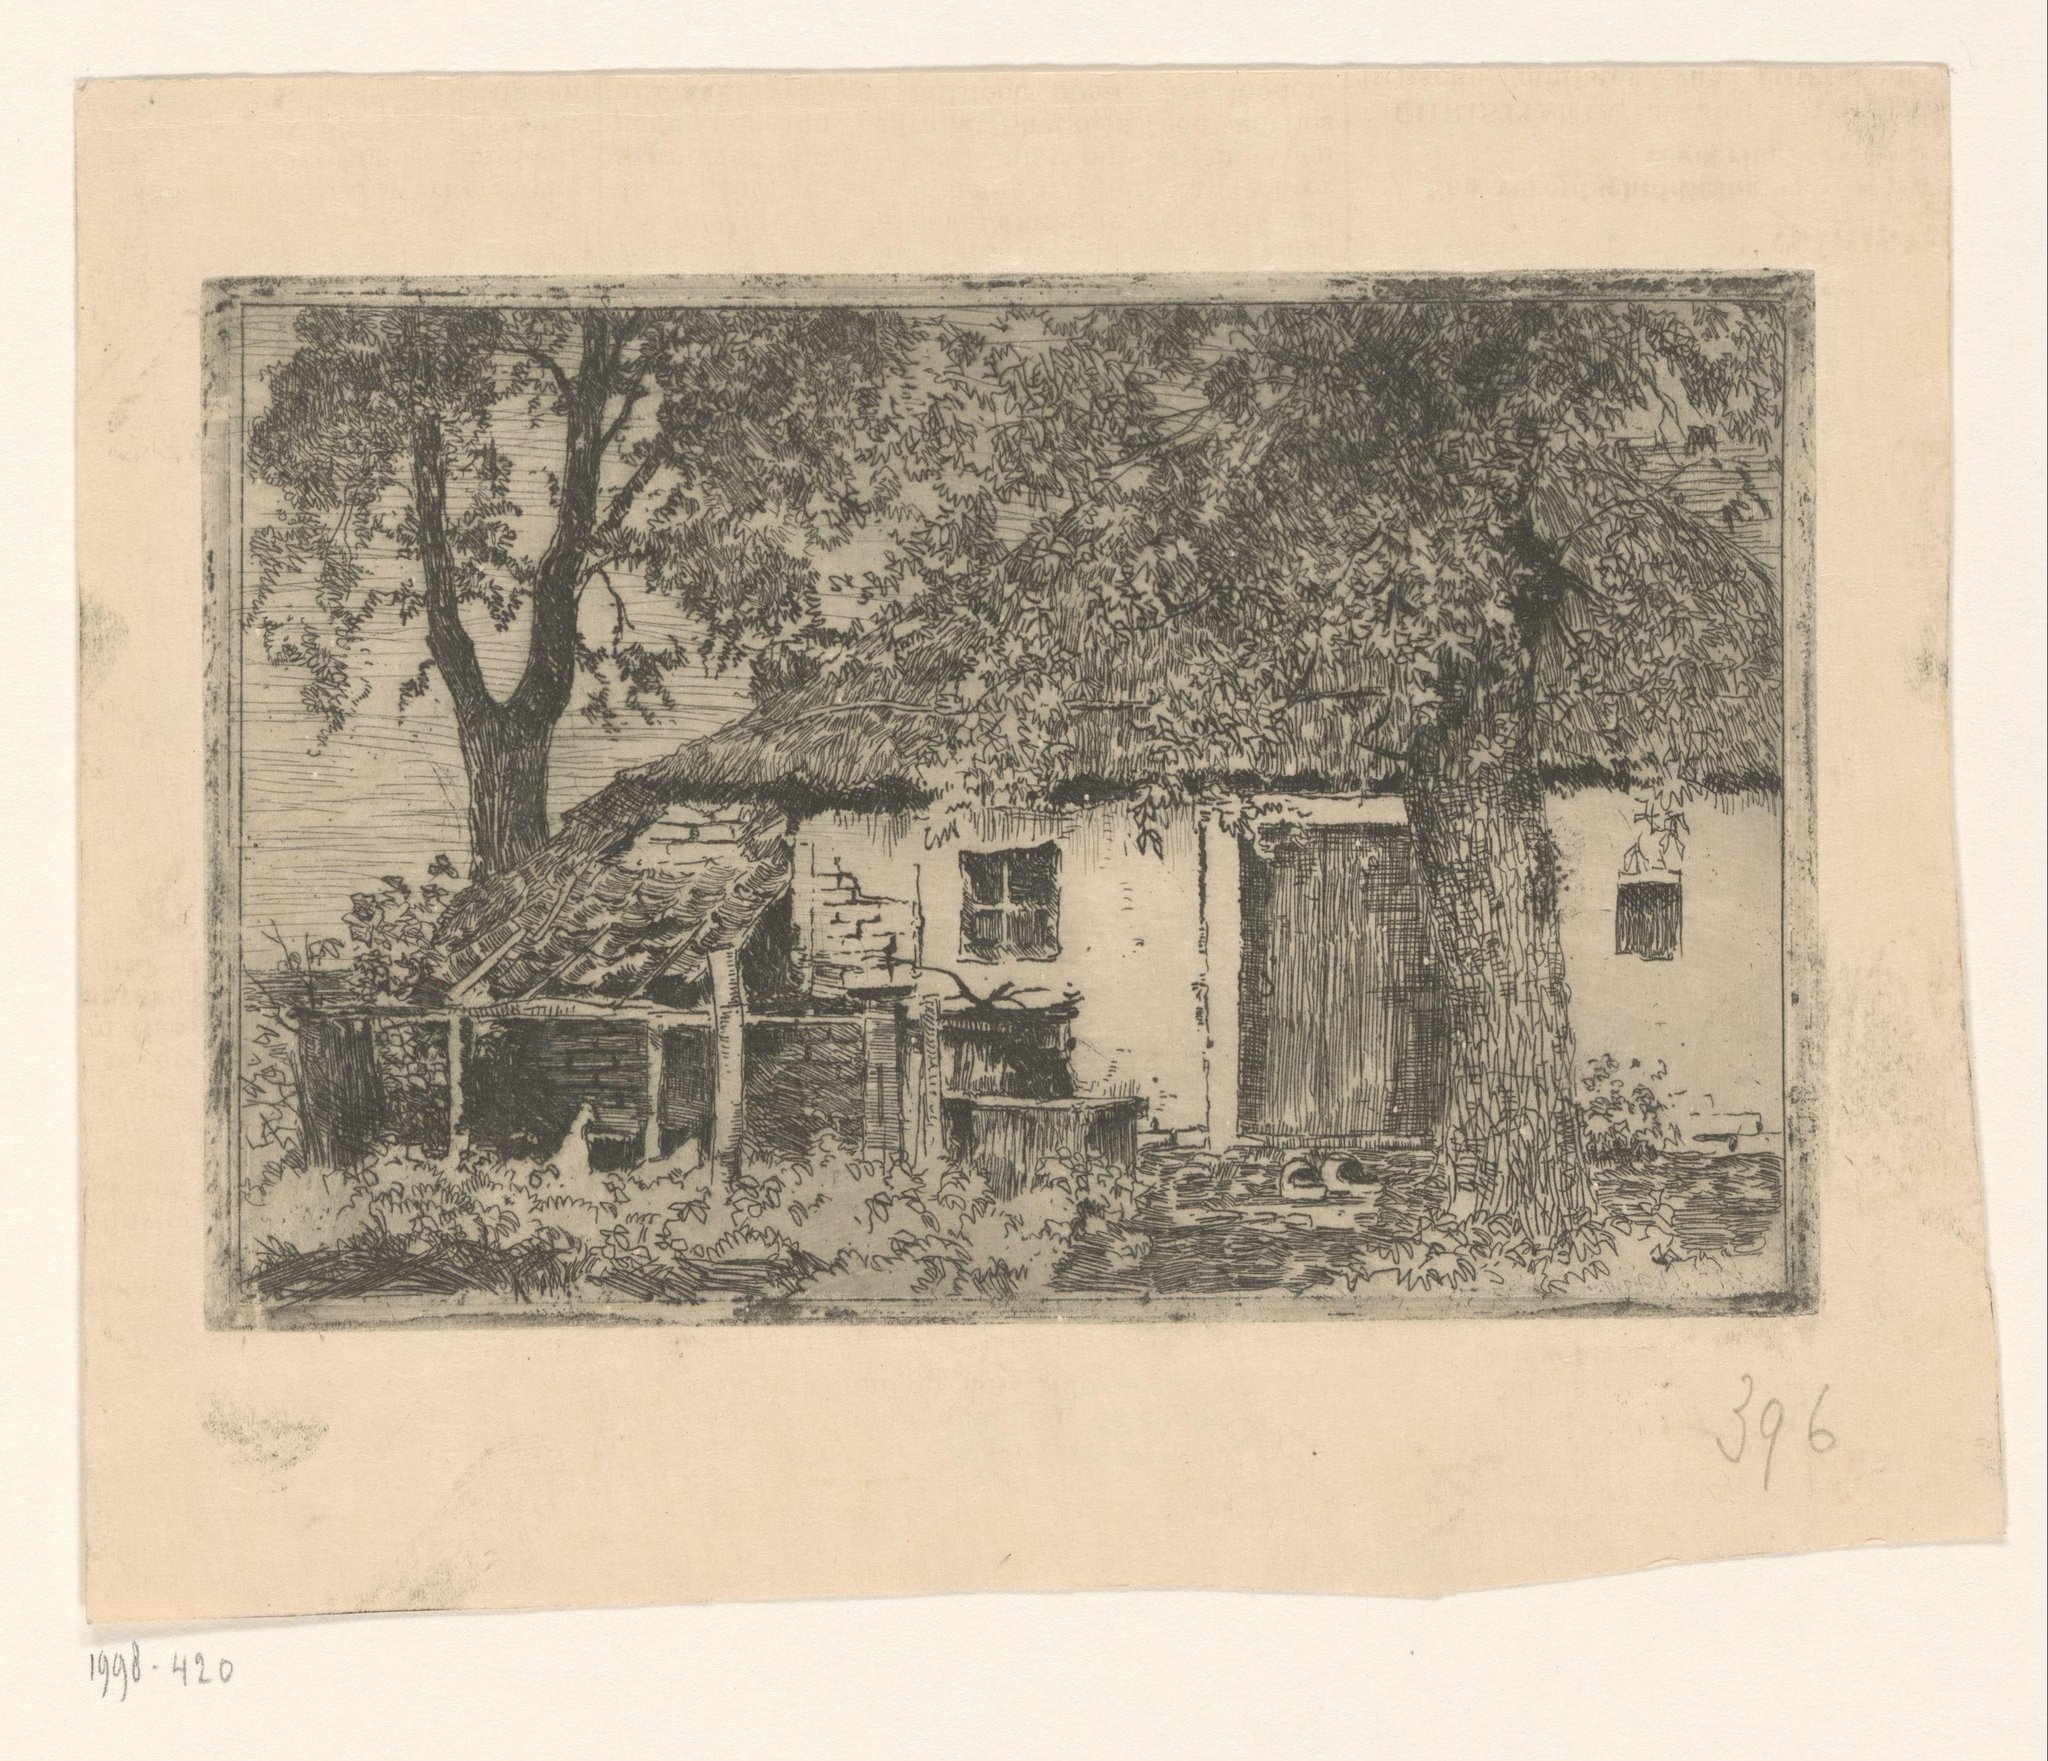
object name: print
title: Boerderij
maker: cornelis vreedenburgh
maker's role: draughtsman, print maker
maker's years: 1880-1946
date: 1890-1946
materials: paper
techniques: etching, intaglio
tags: farm or solitary house in landscape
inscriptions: collector's mark: Lugt 2228, collector's mark: Lugt 2760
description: Een lage boerderij onder bomen, met links een afdak.